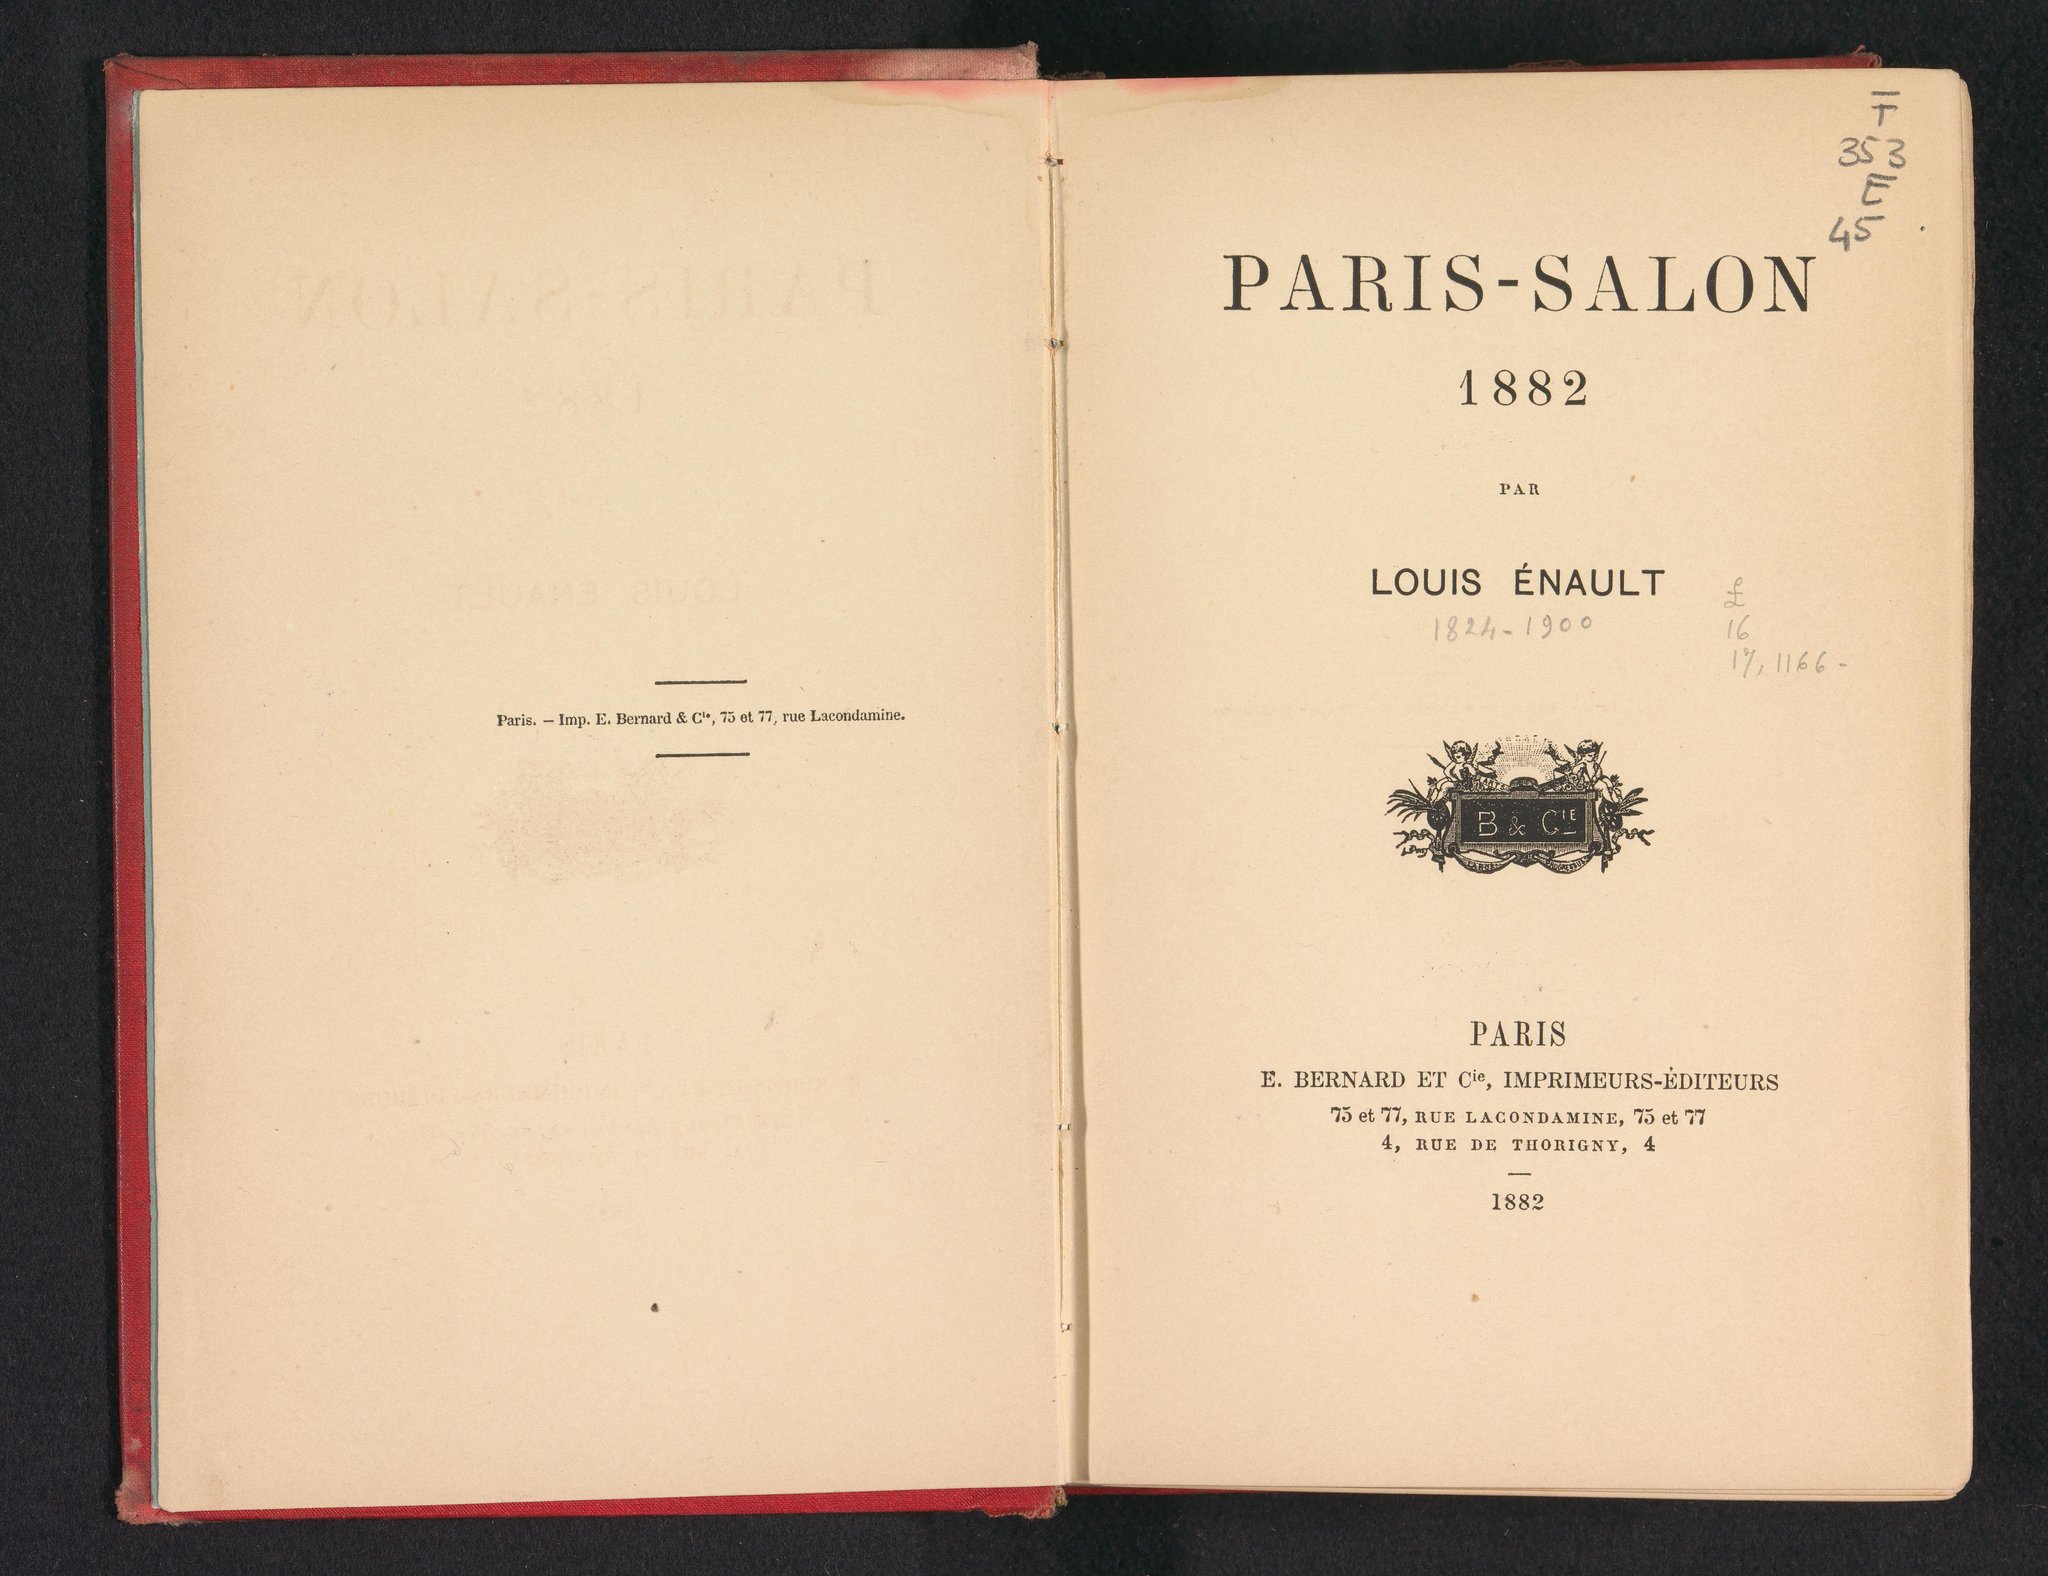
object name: book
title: Paris-Salon 1882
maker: louis énault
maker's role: journalist, schrijver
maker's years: 1824-1900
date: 1882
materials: cardboard, linen, paper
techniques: photograph, printing, woodburytype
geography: paris